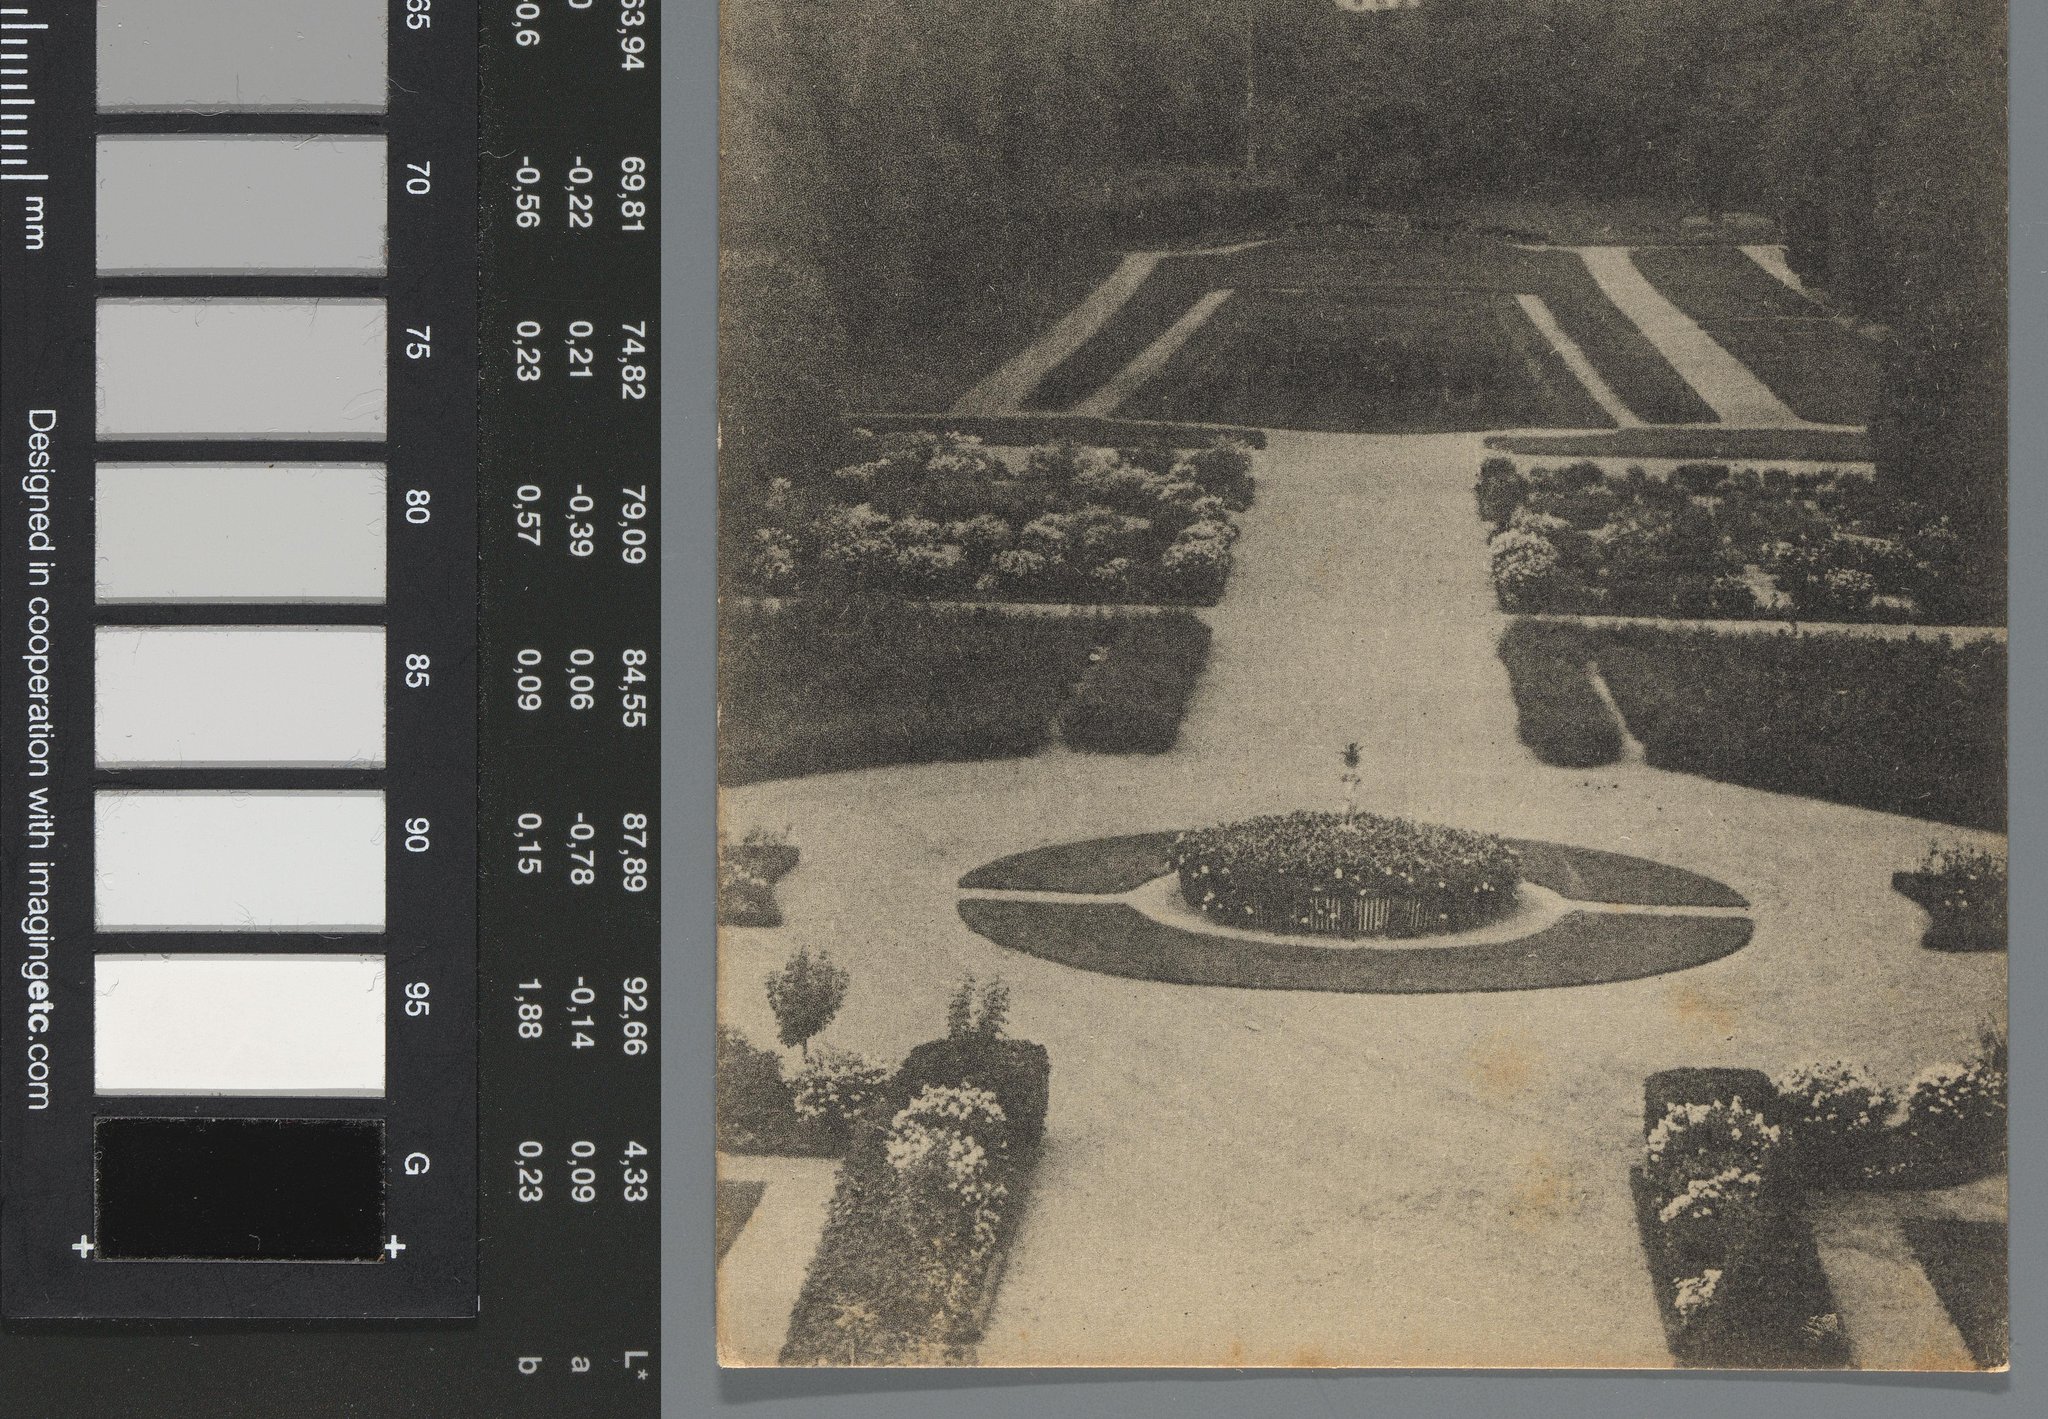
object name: postcard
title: Sturefors, Östergötland, Zweden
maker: swensson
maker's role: fotograaf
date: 1920-1950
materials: photographic support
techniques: photograph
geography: sweden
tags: zweden